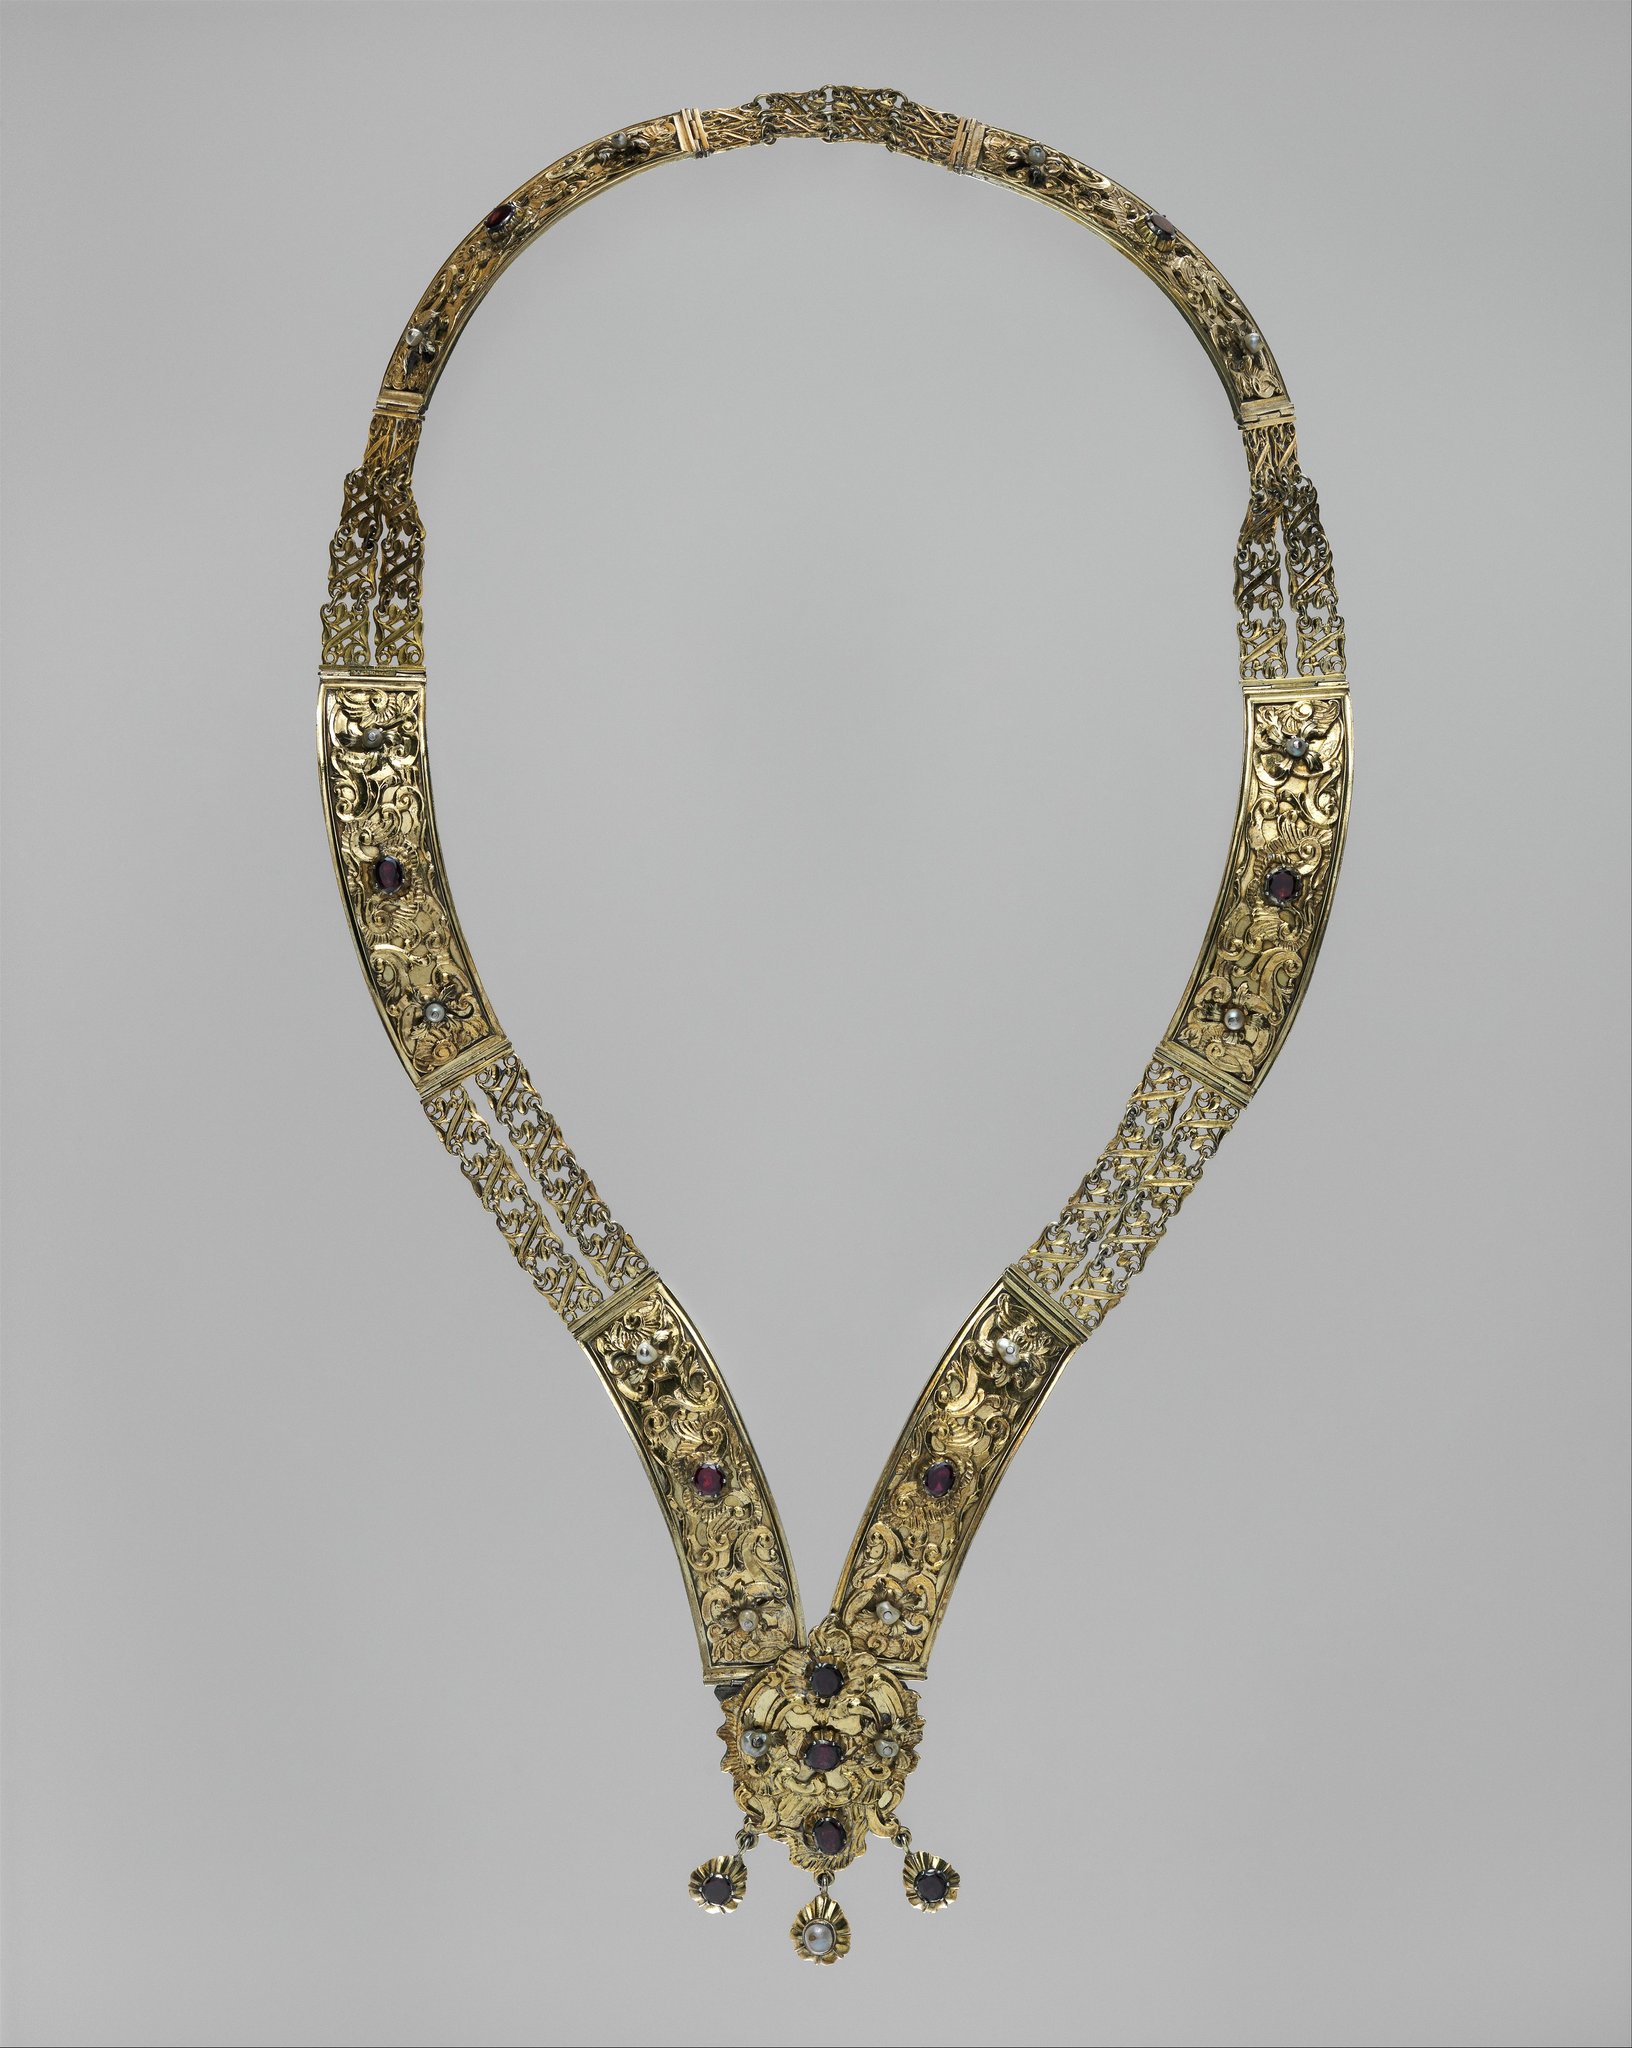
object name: belt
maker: michael erkeder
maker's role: maker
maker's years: 1656-1756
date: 1734-1766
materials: garnet, pearl, silver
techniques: gilding